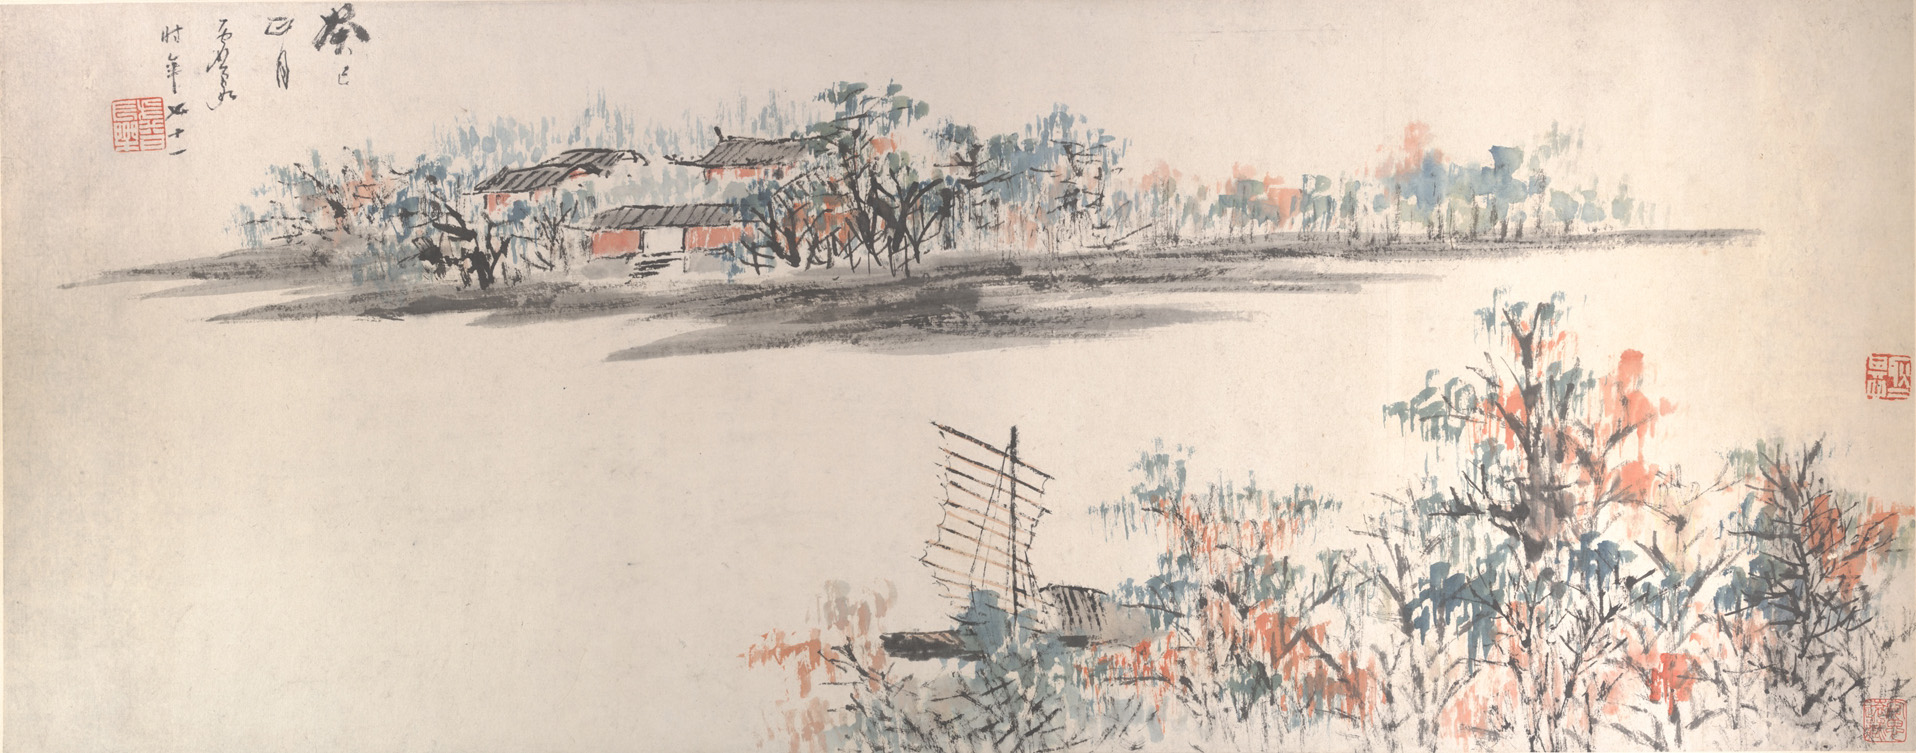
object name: album leaf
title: Sailing in Autumn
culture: chinese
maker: xugu (zhu huairen)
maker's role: artist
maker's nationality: chinese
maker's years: 1823-1896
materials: ink, paper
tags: landscapes,boats